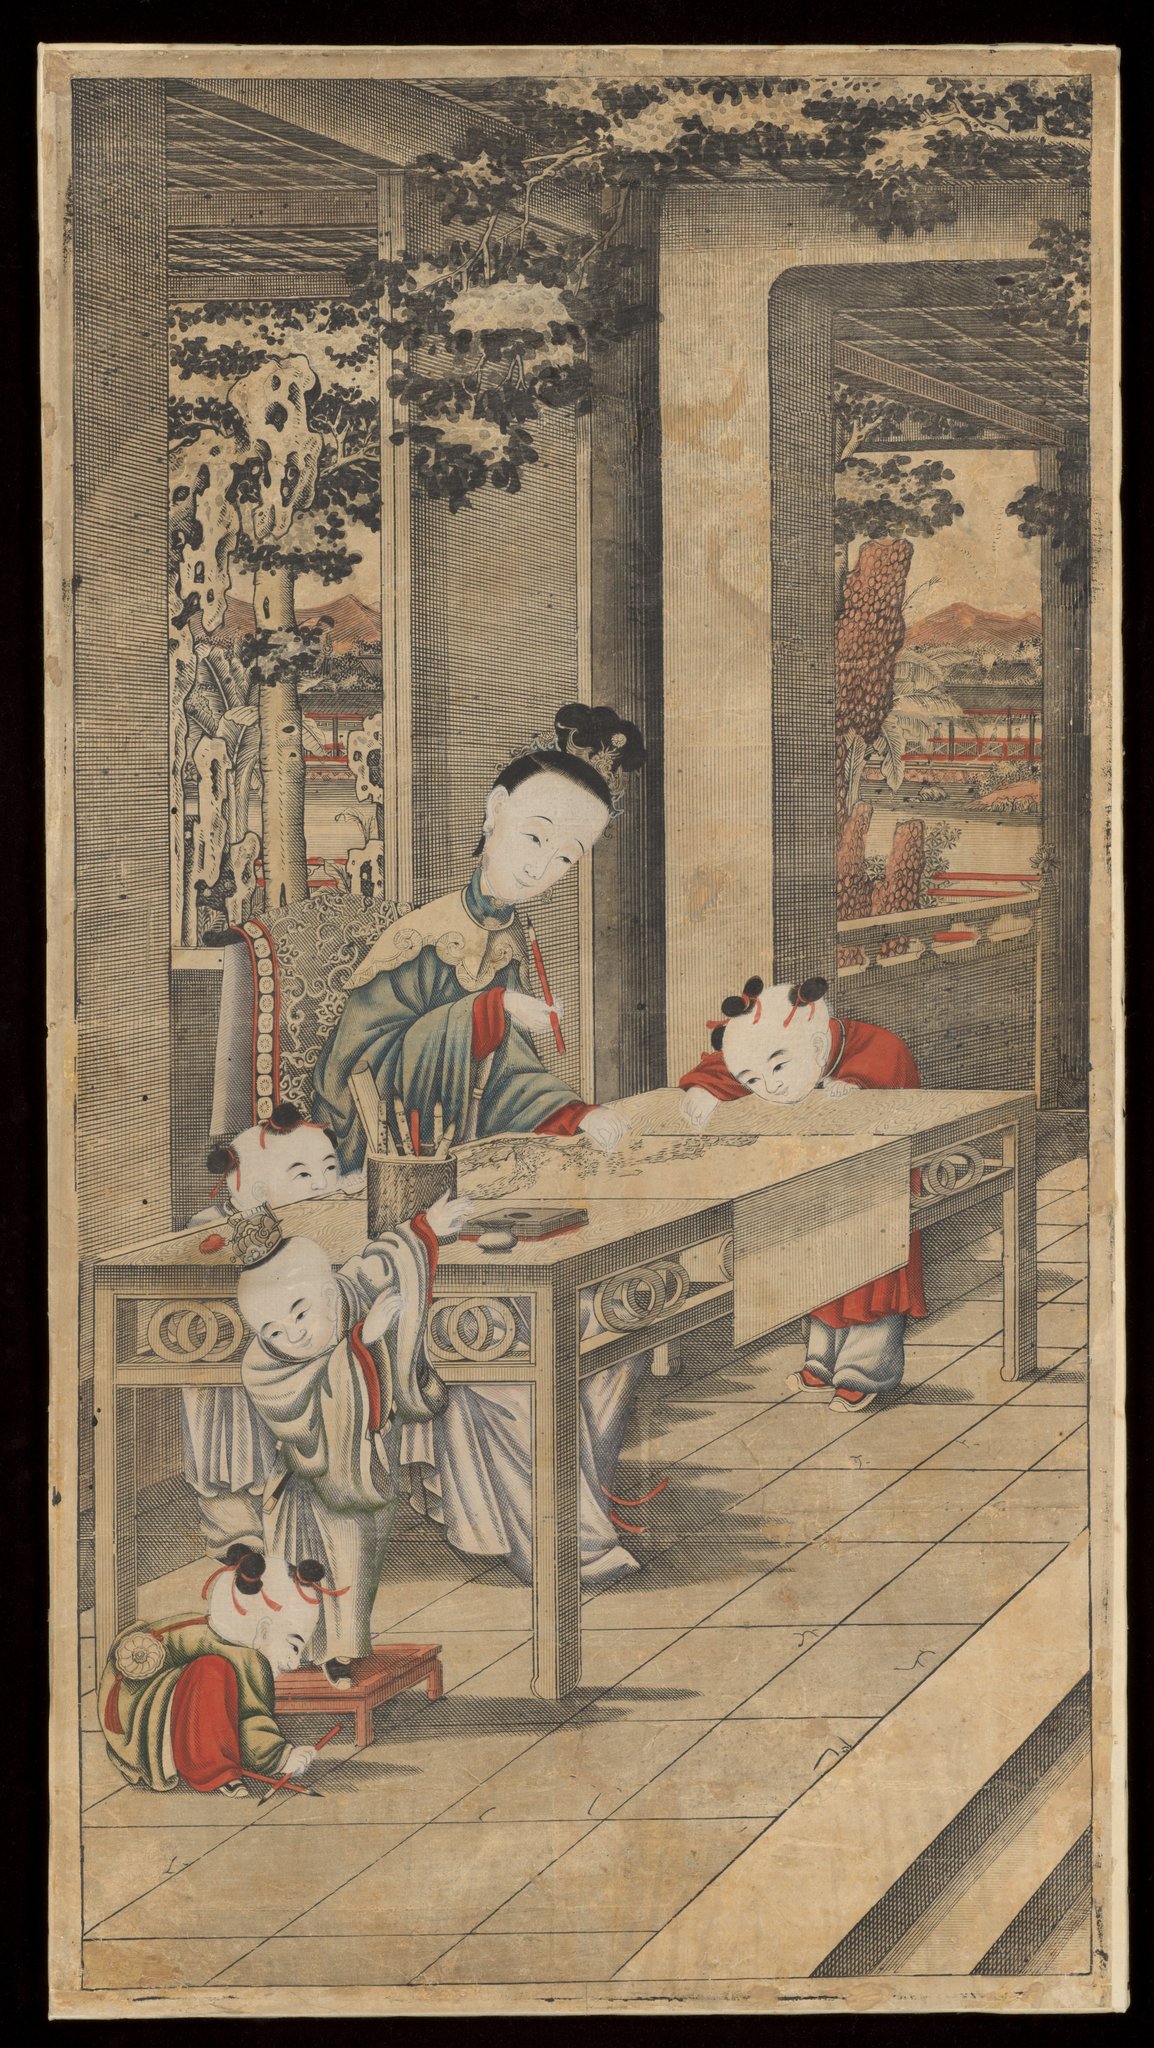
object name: print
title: Woman teaching children to paint, from four-print set “Women teaching children the four accomplishments”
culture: chinese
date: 1736-1795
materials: ink, paper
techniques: hand coloring, woodblock print